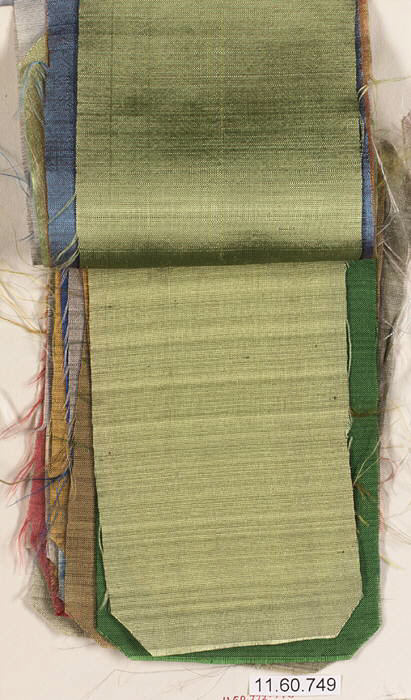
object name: sample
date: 1801-1833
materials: silk